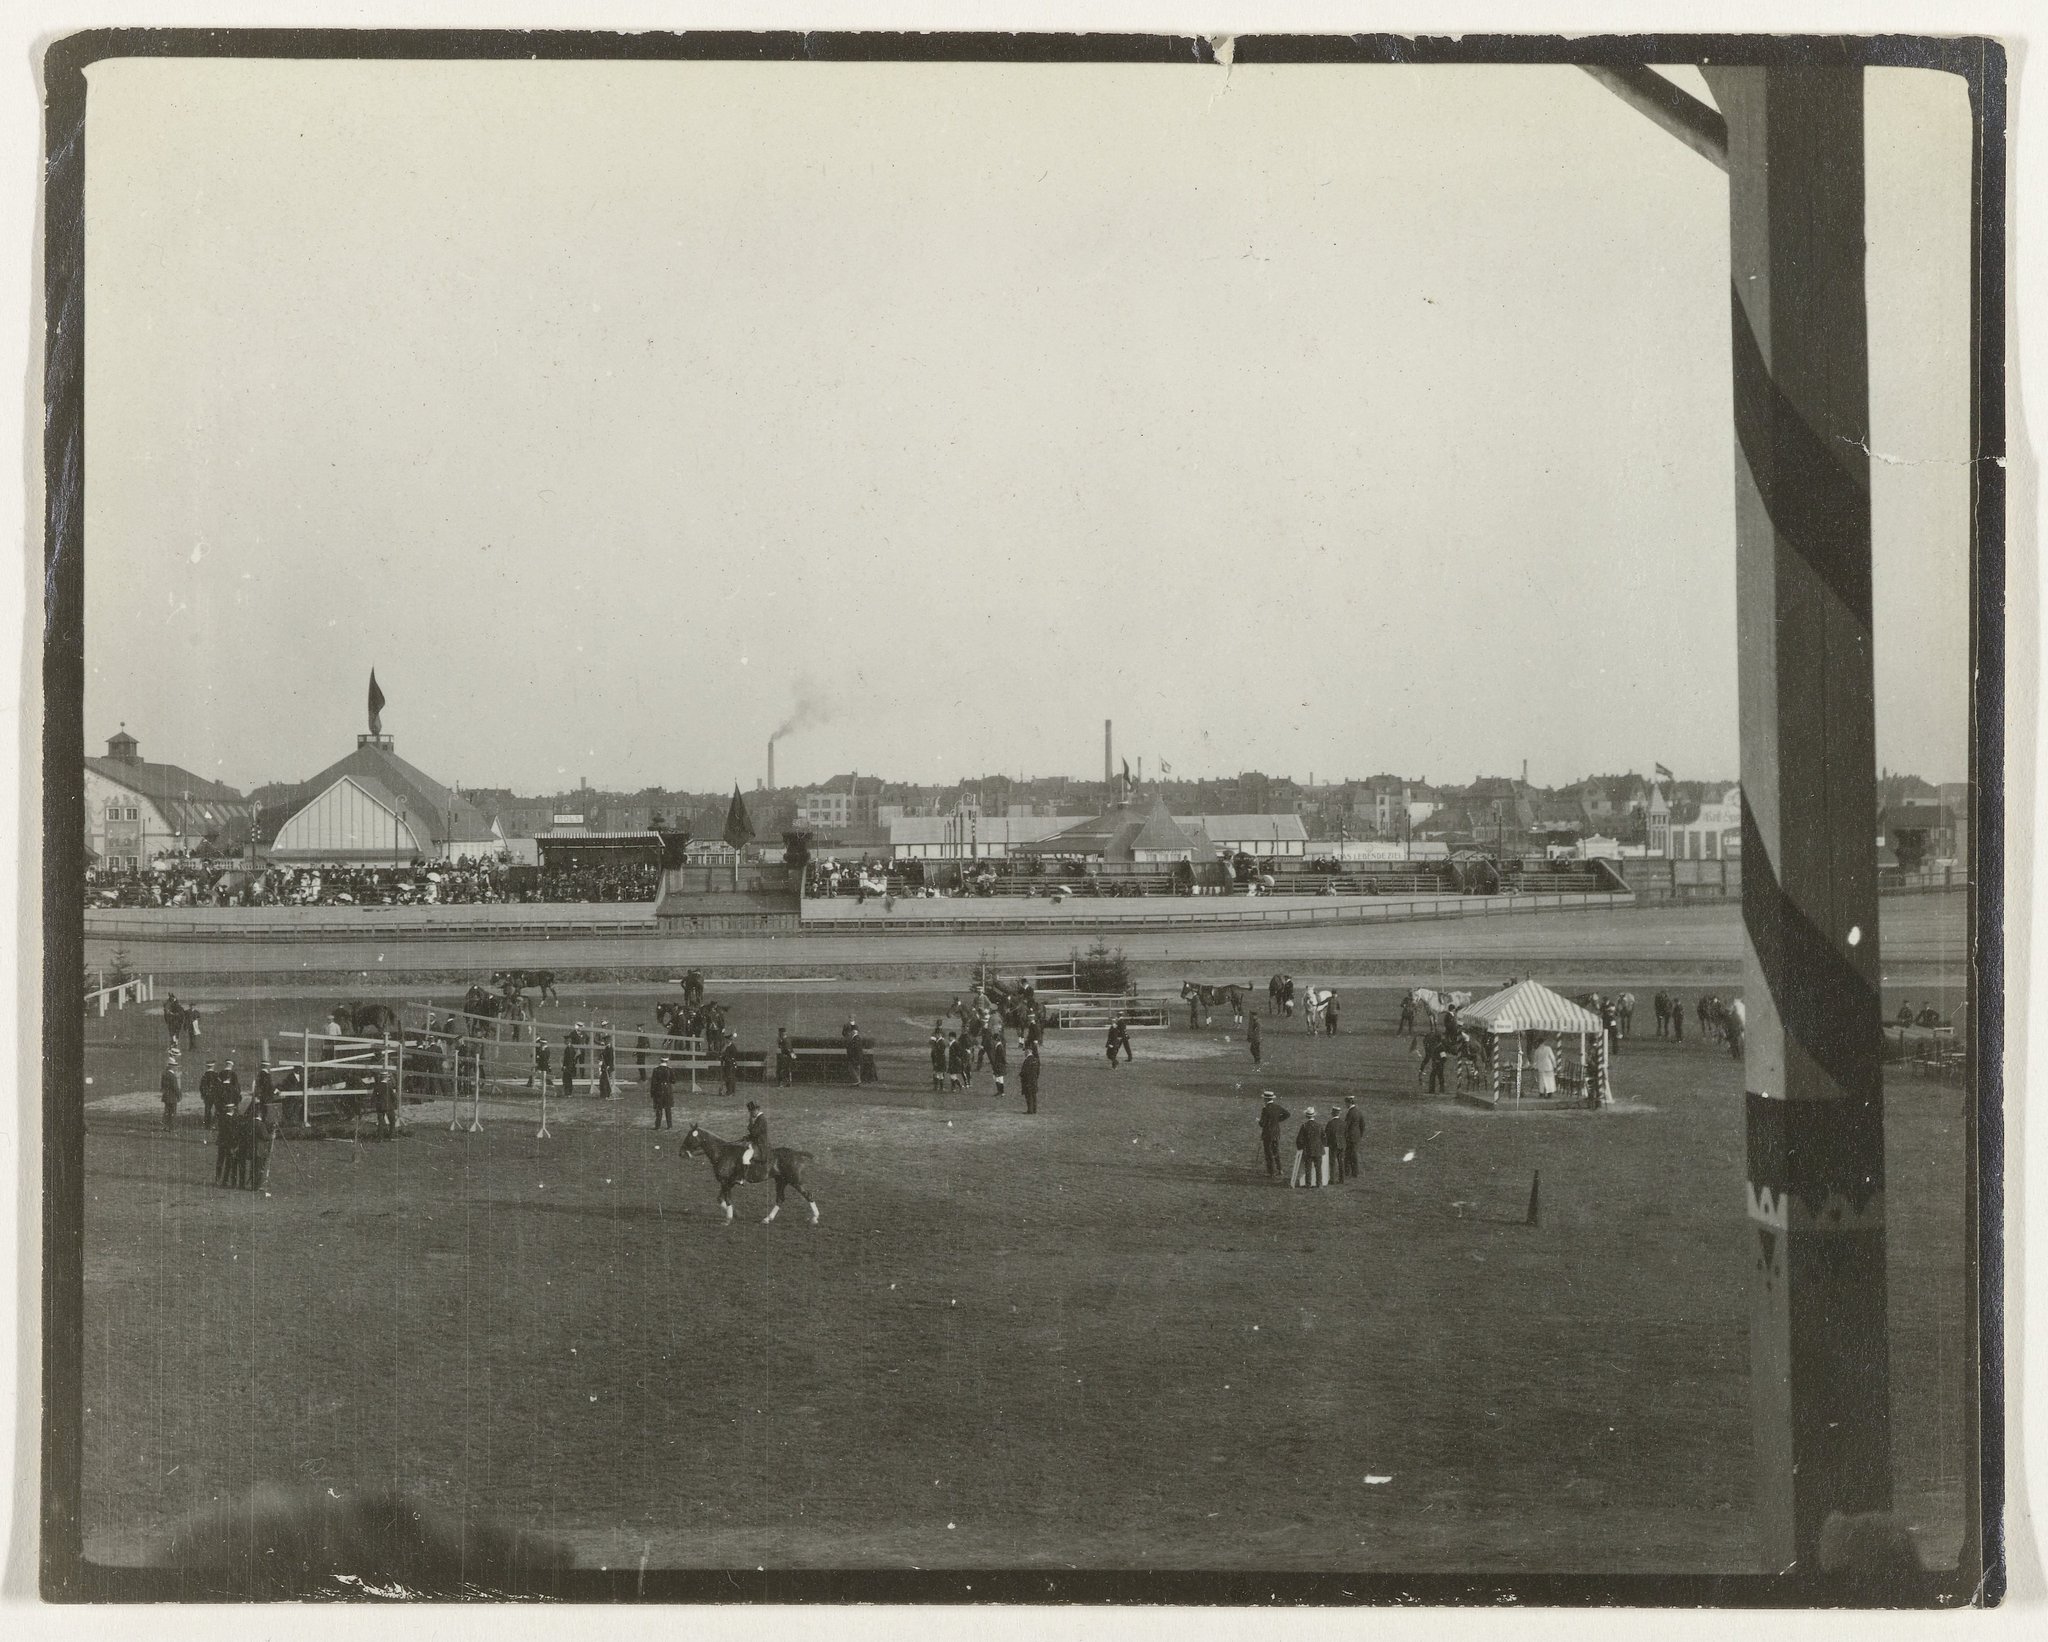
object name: photograph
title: Paardenrenbaan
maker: Anonymous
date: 1900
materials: paper, photographic support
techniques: gelatin silver print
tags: race-track